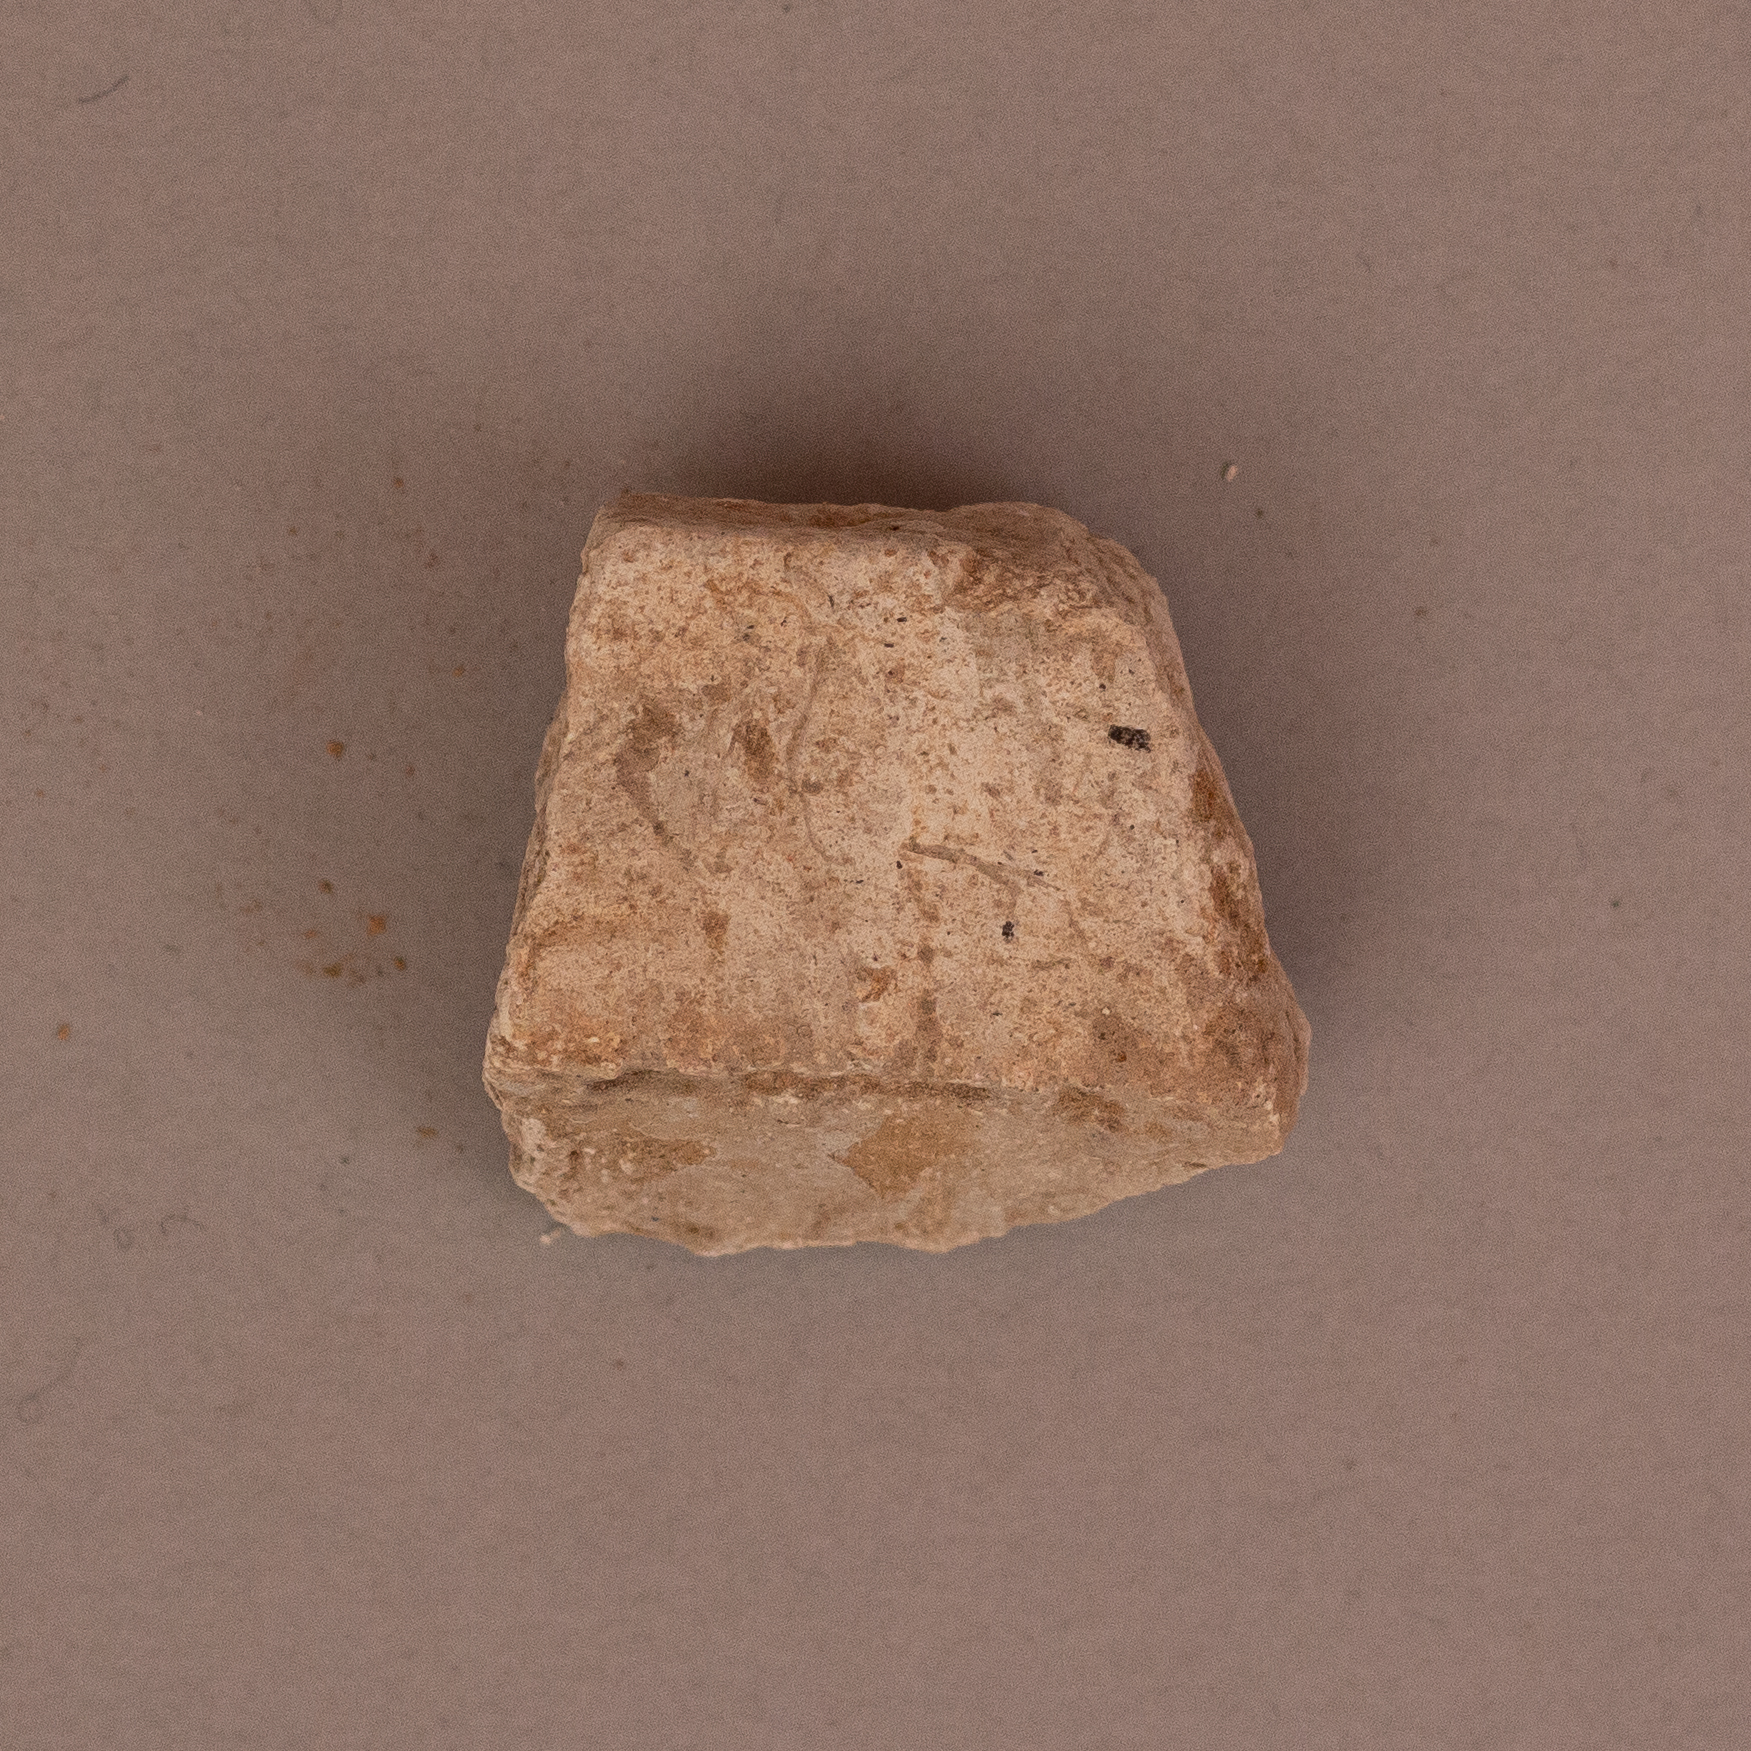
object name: fragment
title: Stucco Fragment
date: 701-1200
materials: plaster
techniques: carving, painting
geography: iran